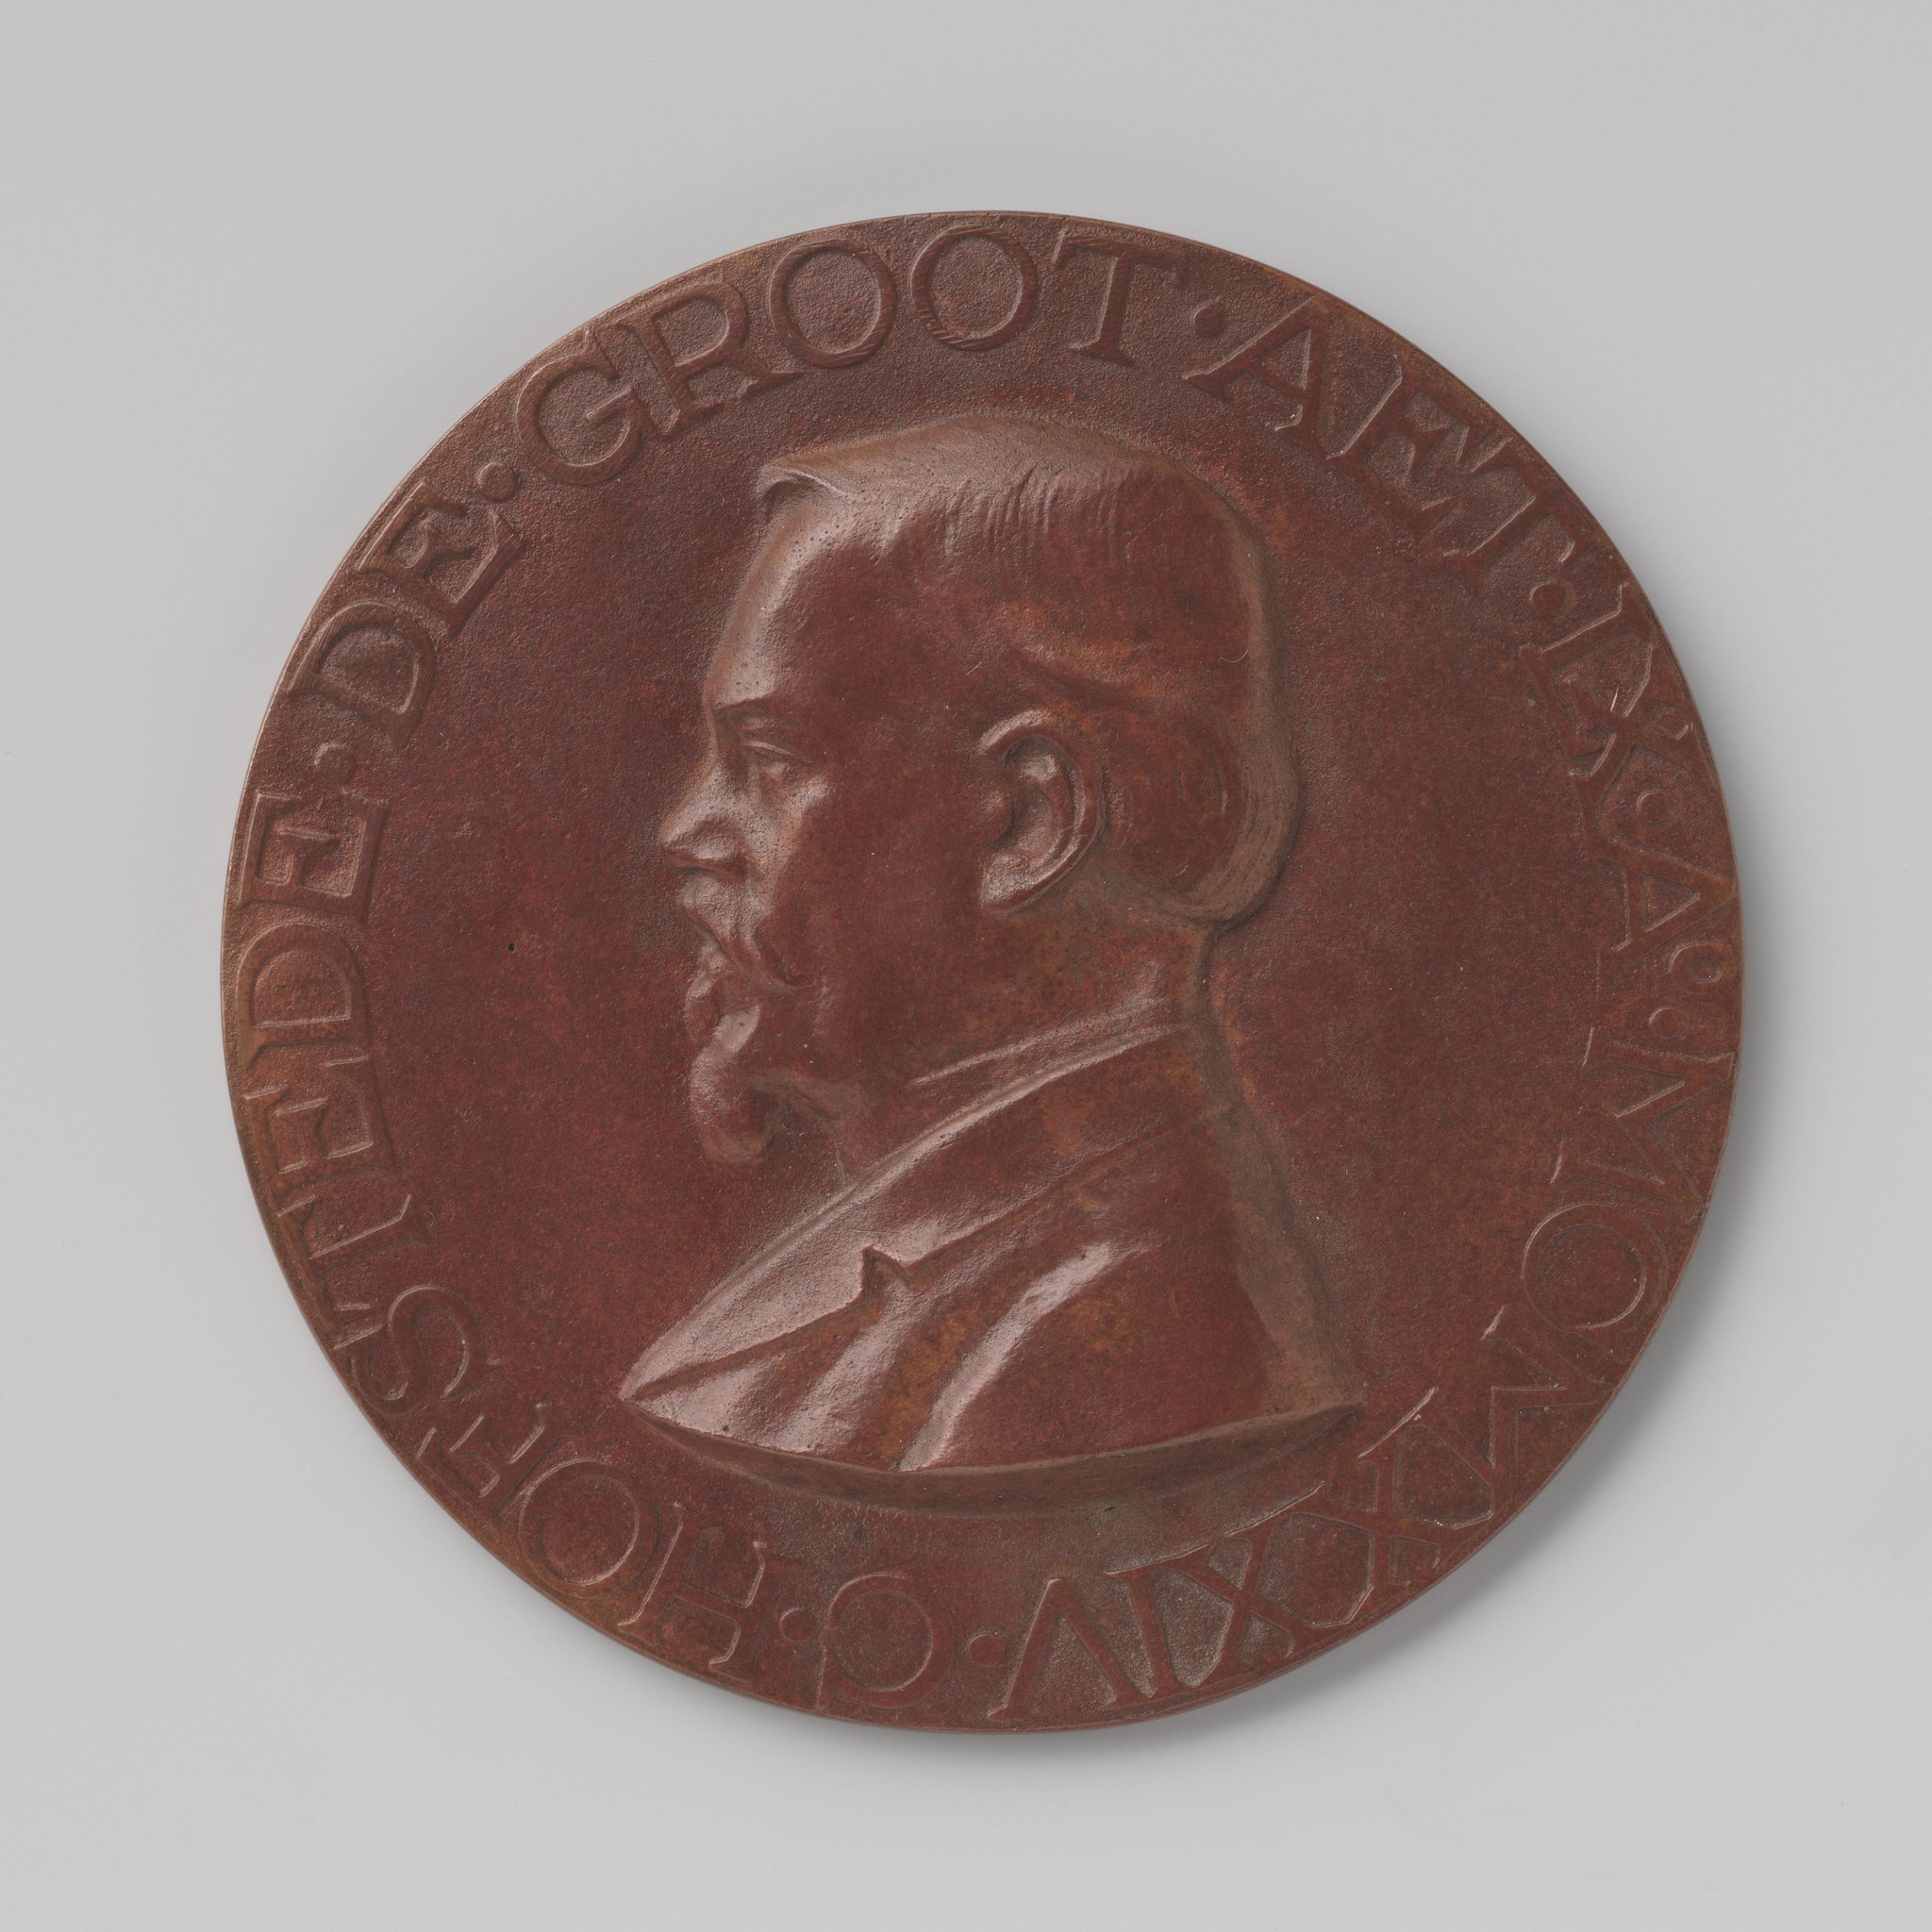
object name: medal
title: Cornelis Hofstede de Groot 60 jaar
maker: bon ingenhousz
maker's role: print maker, sculptor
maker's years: 1881-1953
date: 1924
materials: bronze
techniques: striking